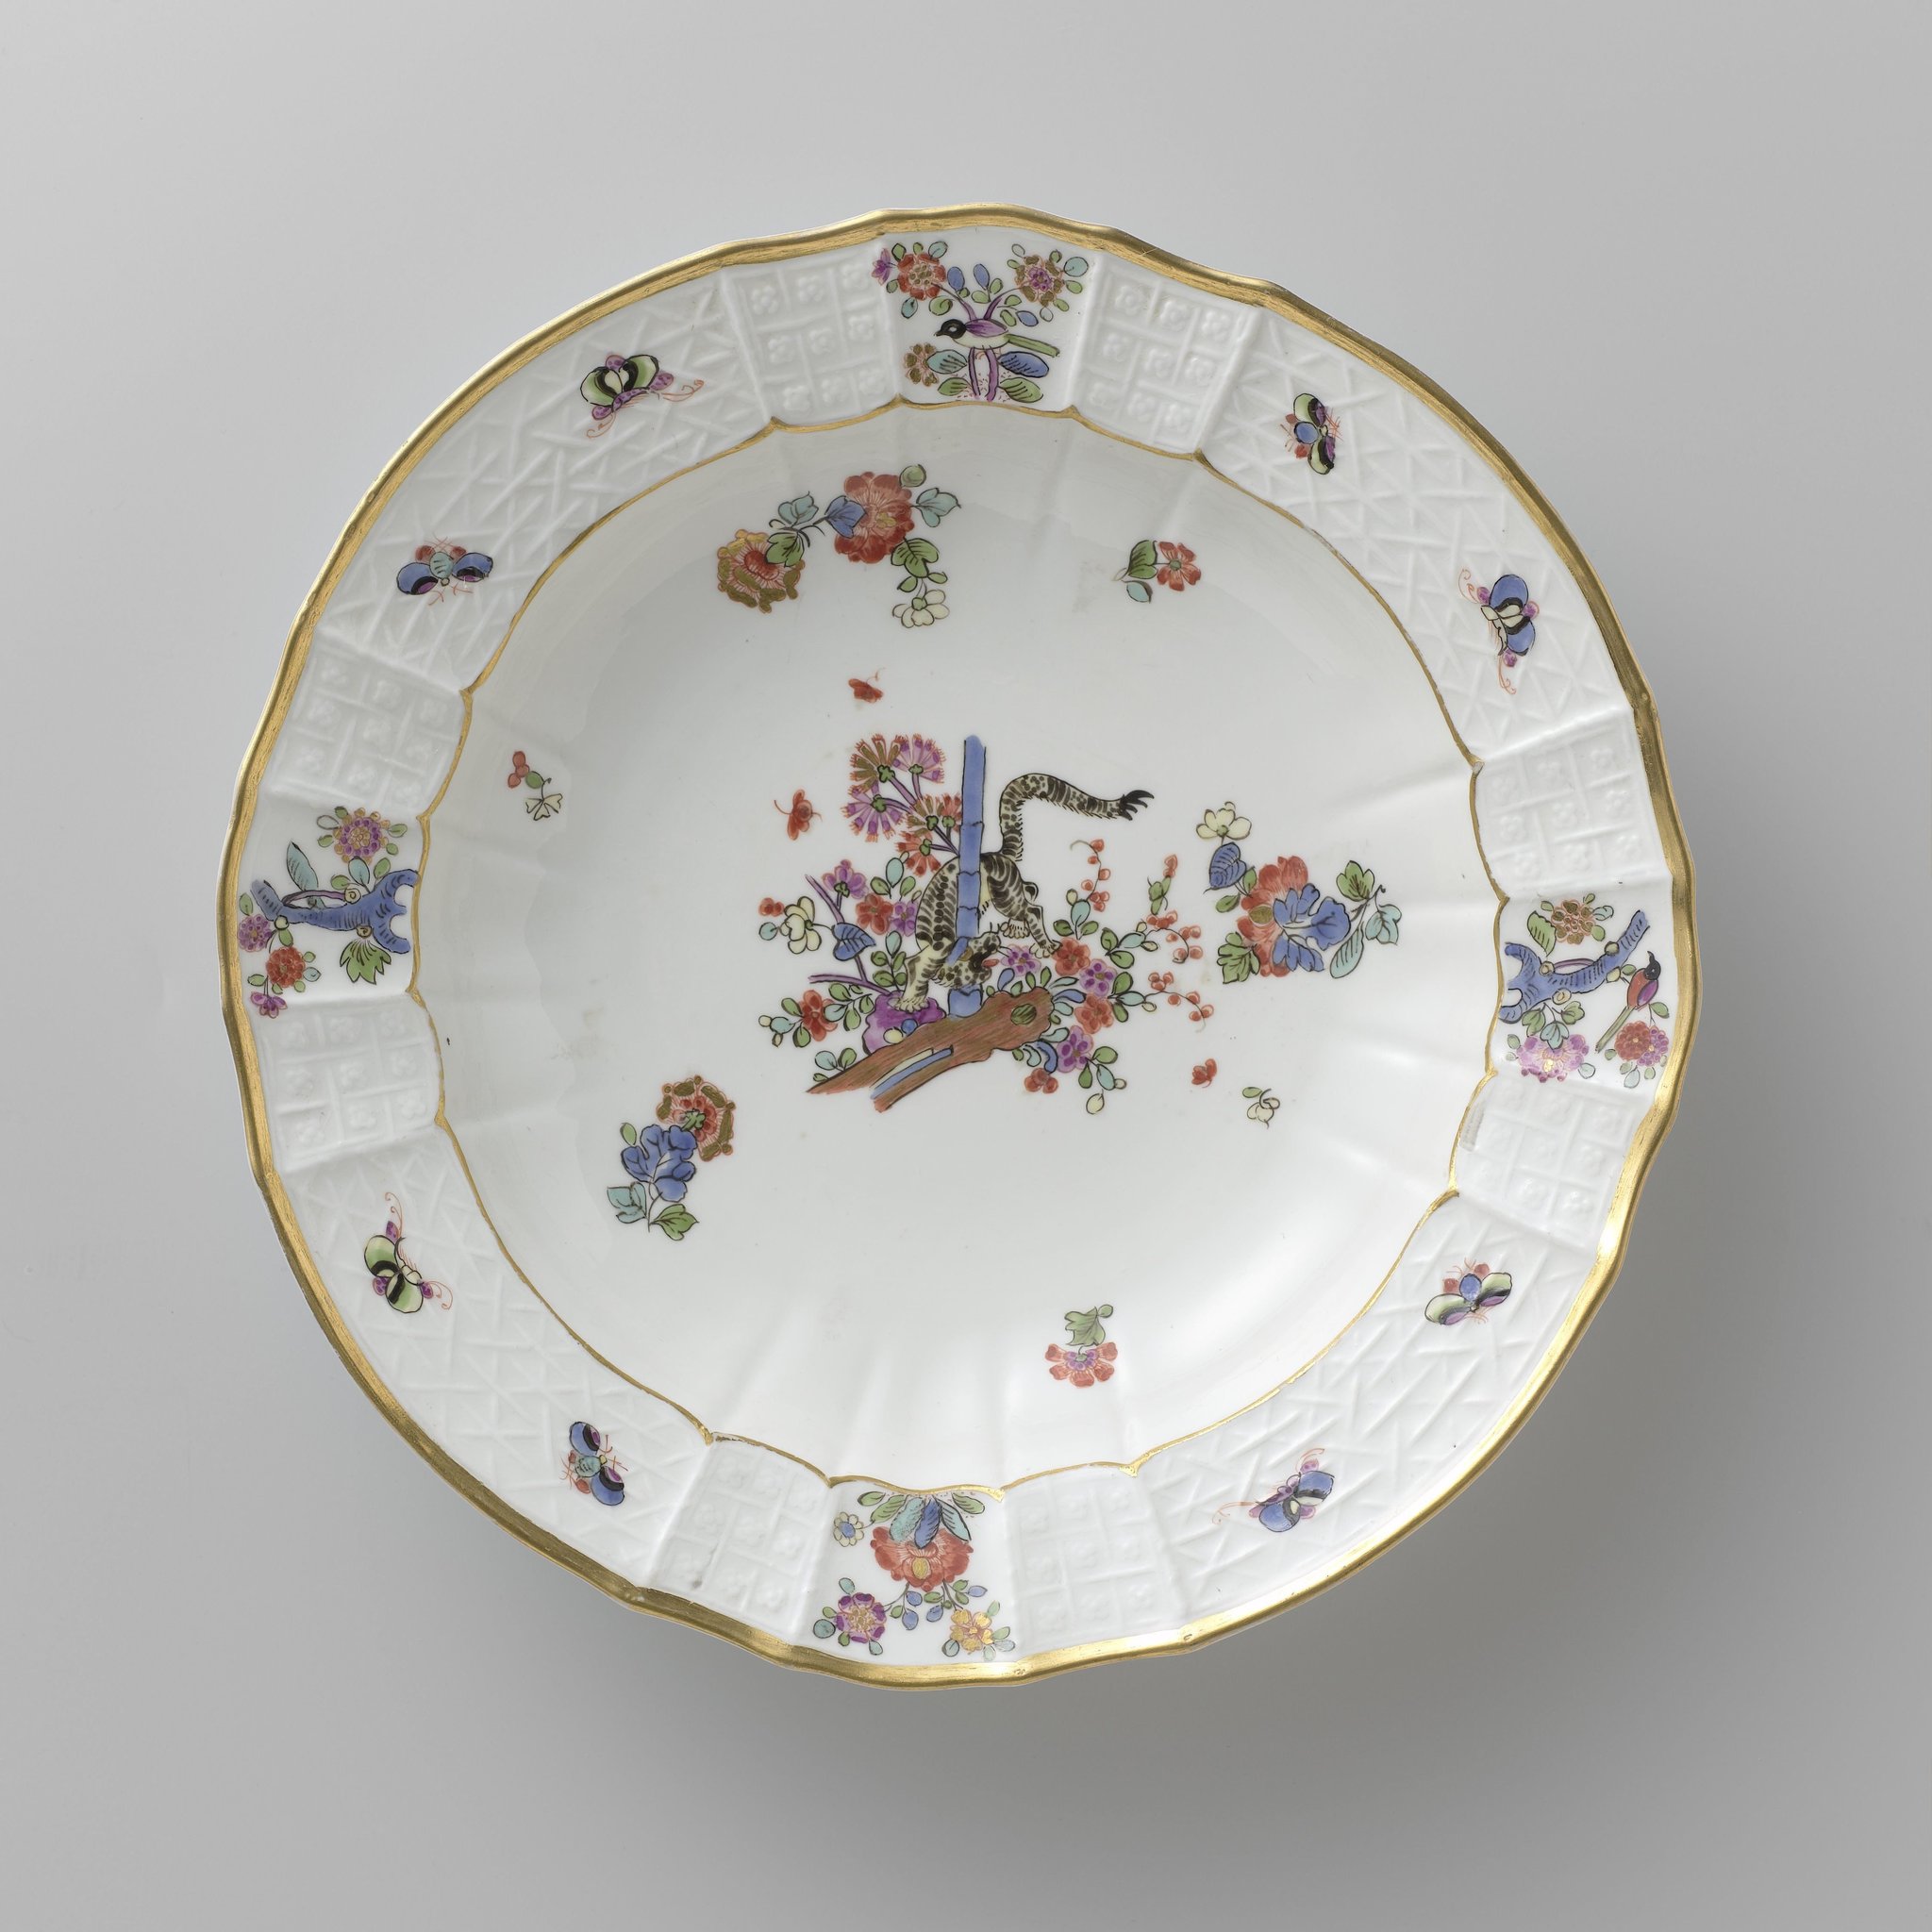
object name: soup plate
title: Soepbord, veelkleurig beschilderd met een Kakiemon-decor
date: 1740-1745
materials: porcelain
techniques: painted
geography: meissen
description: Soepbord van beschilderd porselein. Het bord heeft een geribde en geschulpte rand. Het bord is beschilderd met een tijger, die zich tussen bloemen om een bamboestengel draait, gestrooide Indianische Blumen, vlinders en takken met vogels. De rand is versierd met het 'Altbrandenstein'-patroon. Het bord is gemerkt.